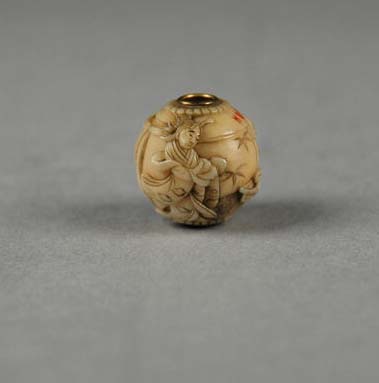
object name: bead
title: Carved Bead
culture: japanese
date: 1801-1900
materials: ivory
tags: human figures